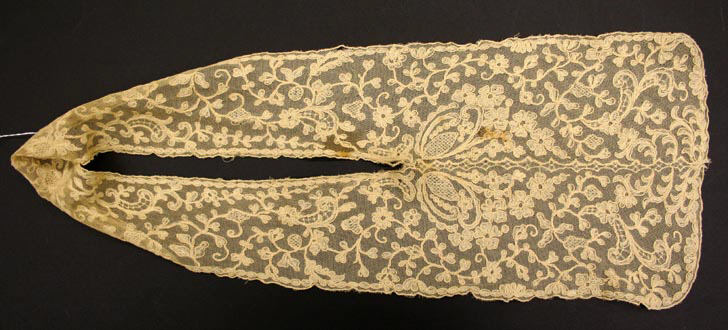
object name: collar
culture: american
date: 1700-1939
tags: flowers